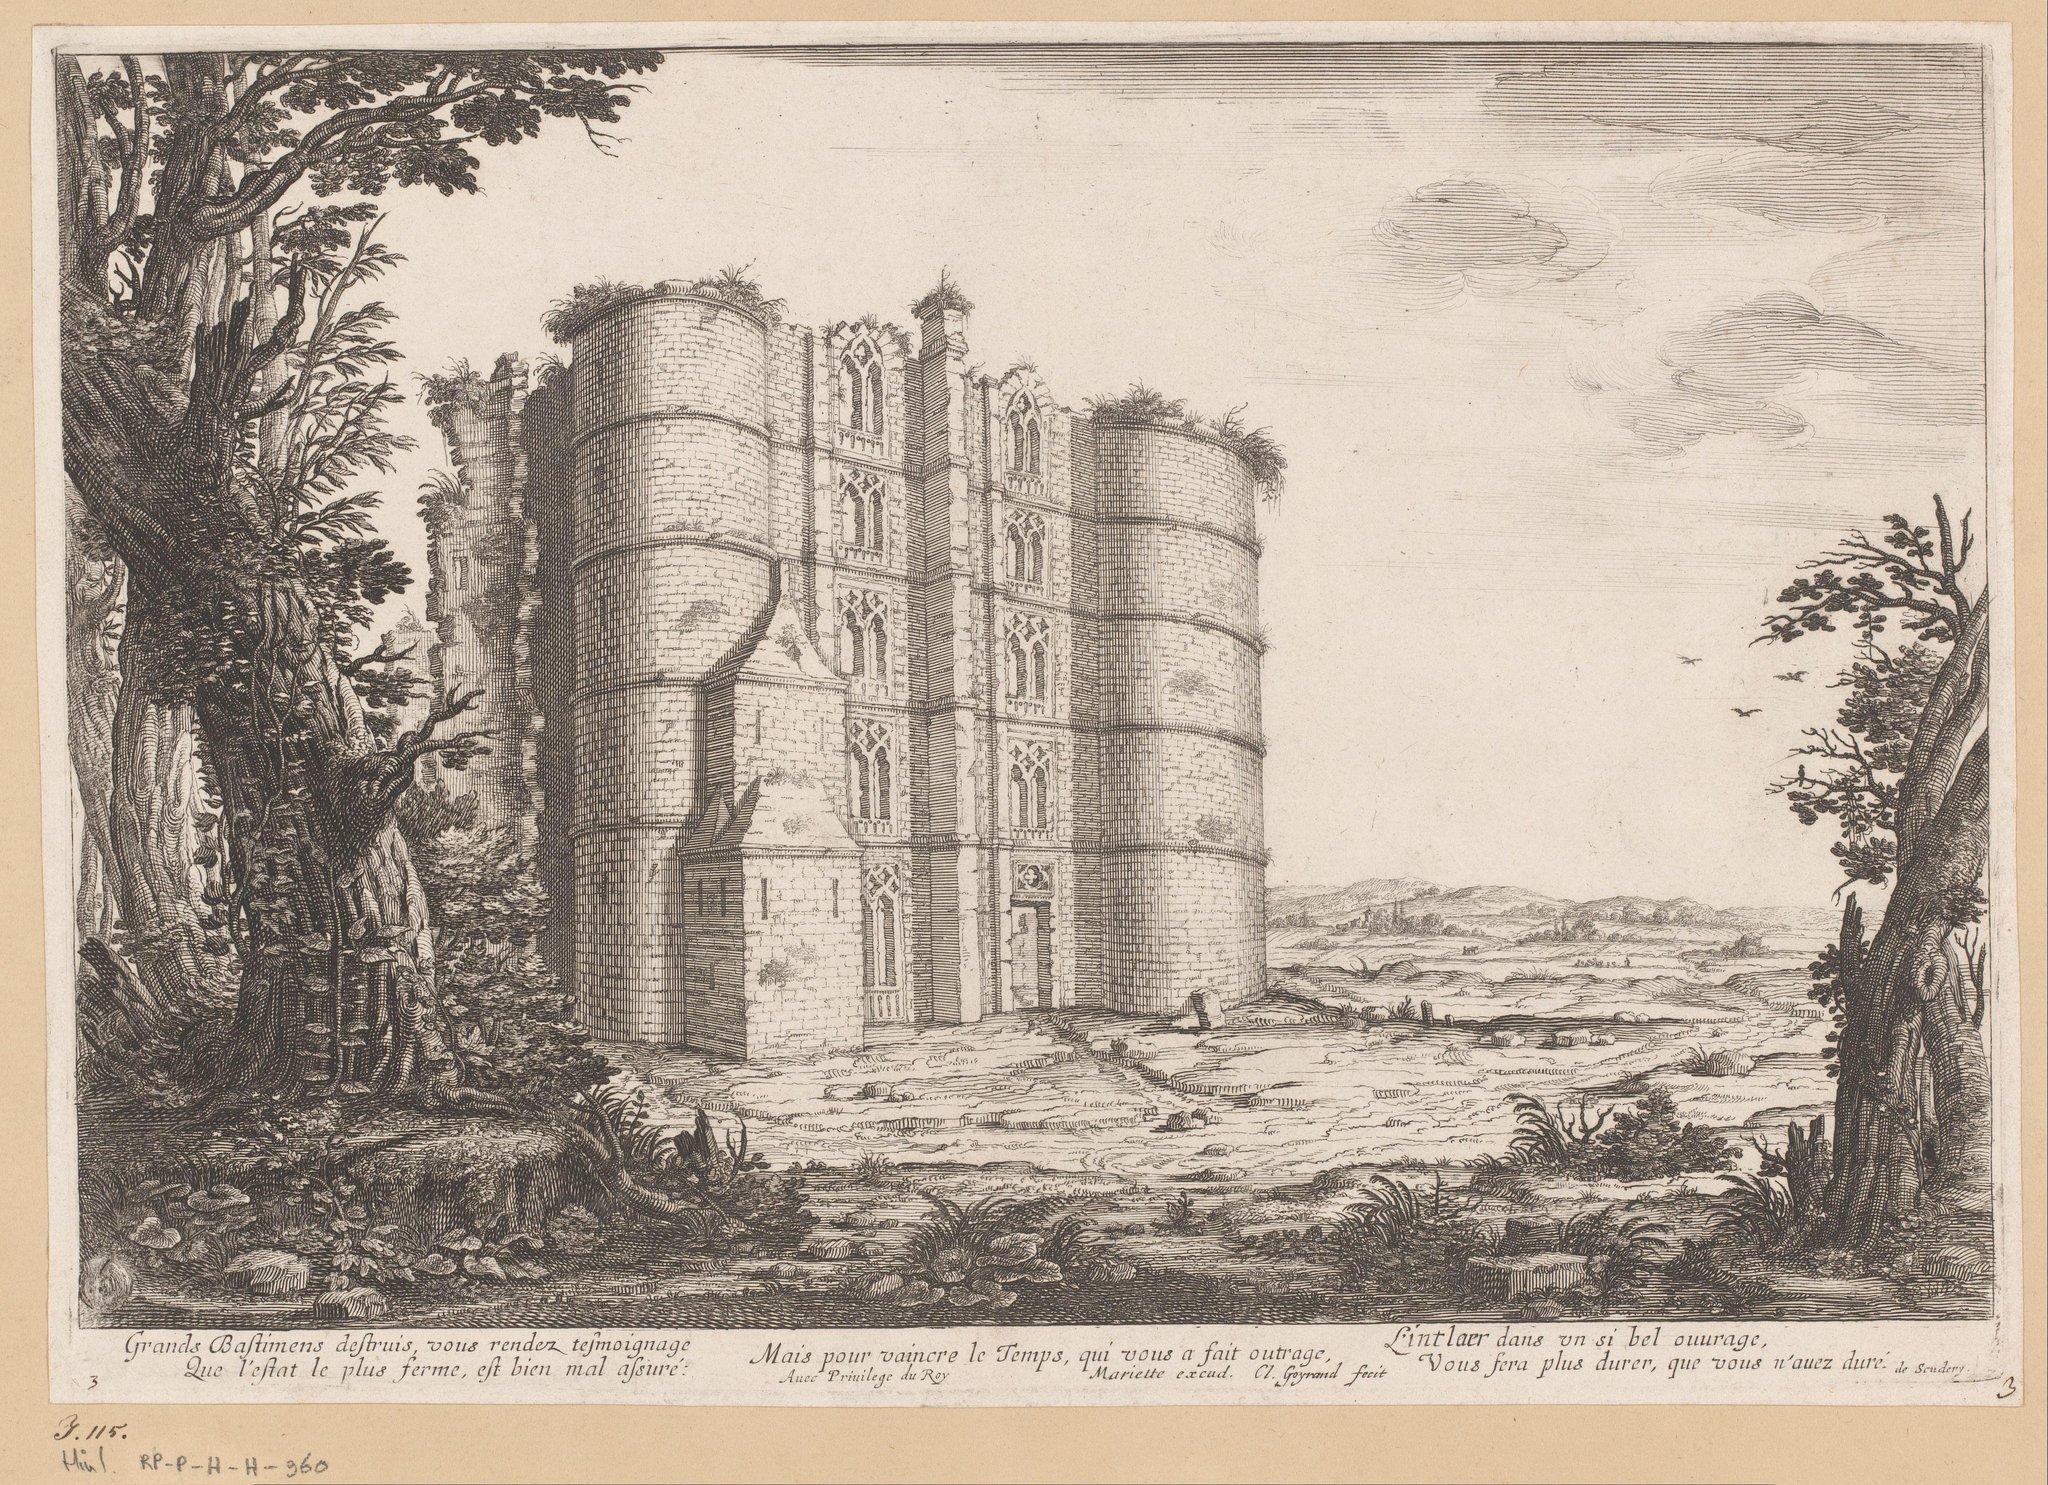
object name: print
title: Gezicht op de ruïne van het kasteel van Bicêtre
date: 1630-1657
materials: paper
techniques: etching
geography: france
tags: ruin of a dwelling, house, castle, etc.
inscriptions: collector's mark: Lugt 10, collector's mark: Lugt 11, number: ‘3’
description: Maakt deel uit van een onbekende serie, waarschijnlijk van gezichten op ruïnes van het kasteel van Bicêtre. In de collectie van het Rijksmuseum bevinden zich drie prenten uit deze vermoedelijke serie.